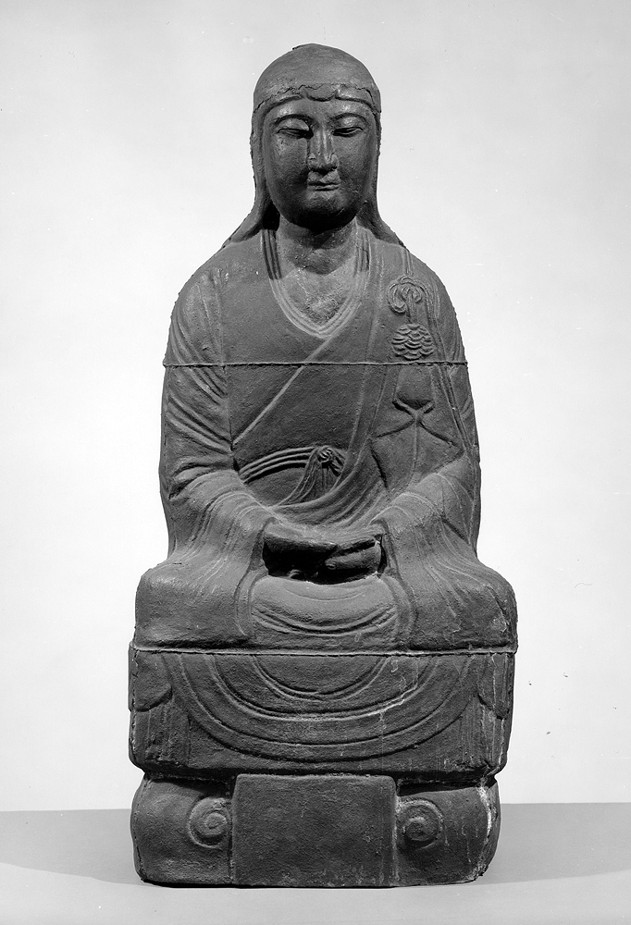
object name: figure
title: Bodhidharma Seated in Meditation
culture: chinese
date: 1368-1644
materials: iron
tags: men,buddhism